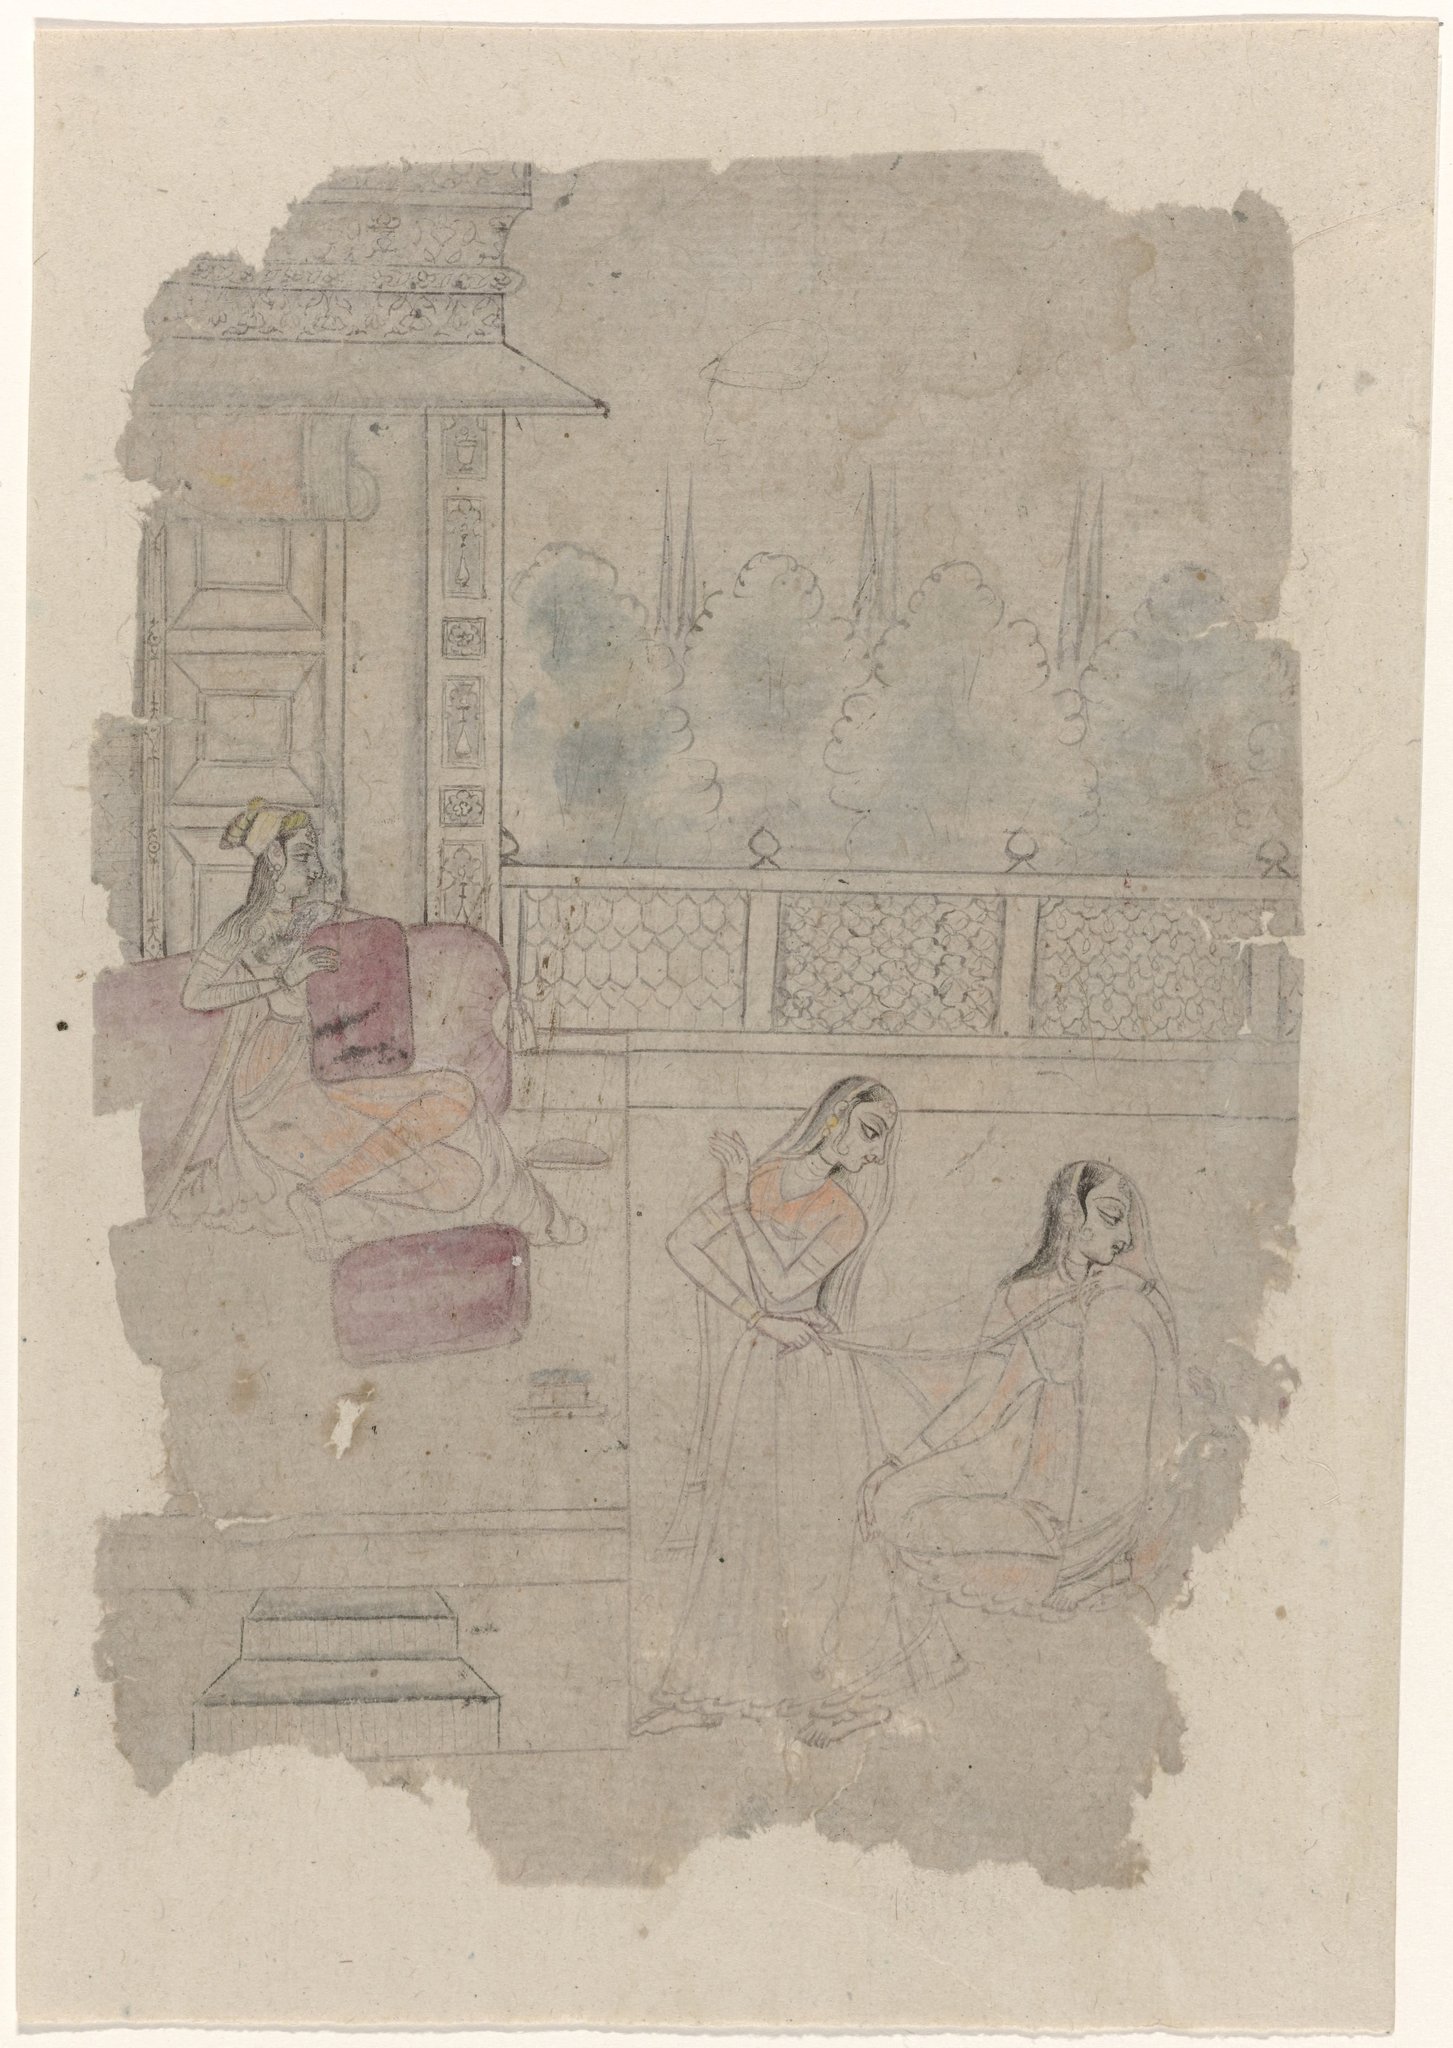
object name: indian miniature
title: Schets van een paar dames op een terras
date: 1800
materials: paper, watercolor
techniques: brush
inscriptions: inscription: ‘64’, inscription: ‘1st// Fish atavar’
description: Een deels ingekleurde tekening van twee vrouwen voor een terras, een zittende en een staande, en een zittende dame op een rolkussen op het terras een kussen tussen haar handen vasthoudend, op de achtergrond een boompartij. De onderkant en beide zijkanten zijn beschadigd en afgescheurd.